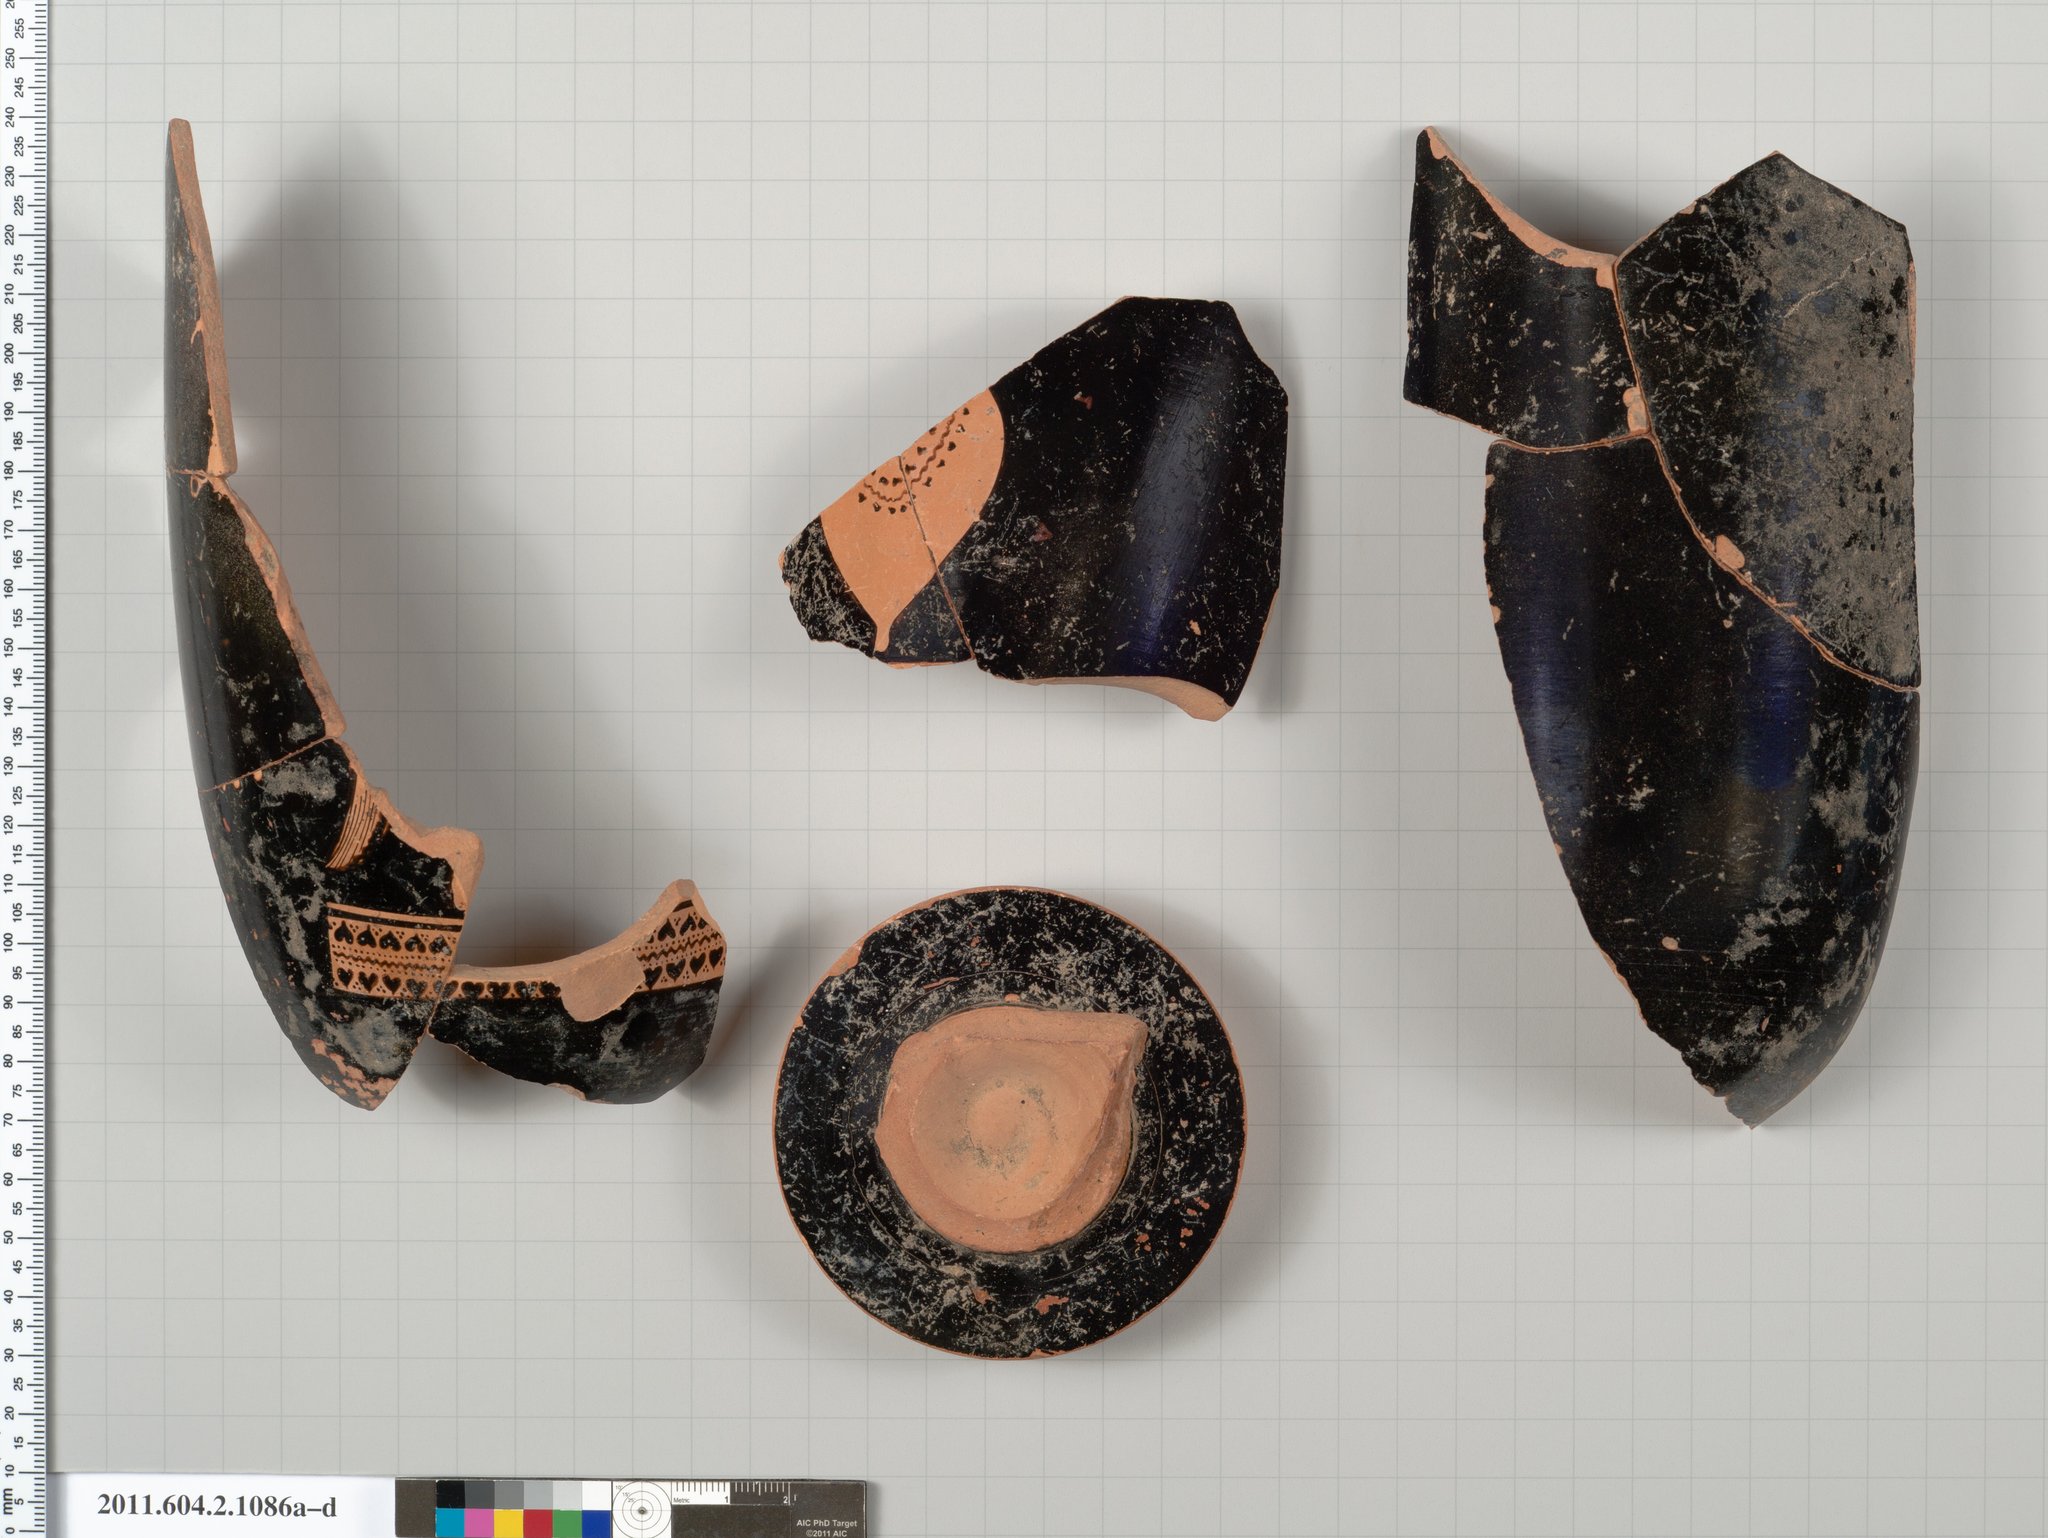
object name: lekythos fragment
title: Terracotta fragments of a lekythos (oil flask)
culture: greek, attic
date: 490-480 BCE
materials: terracotta